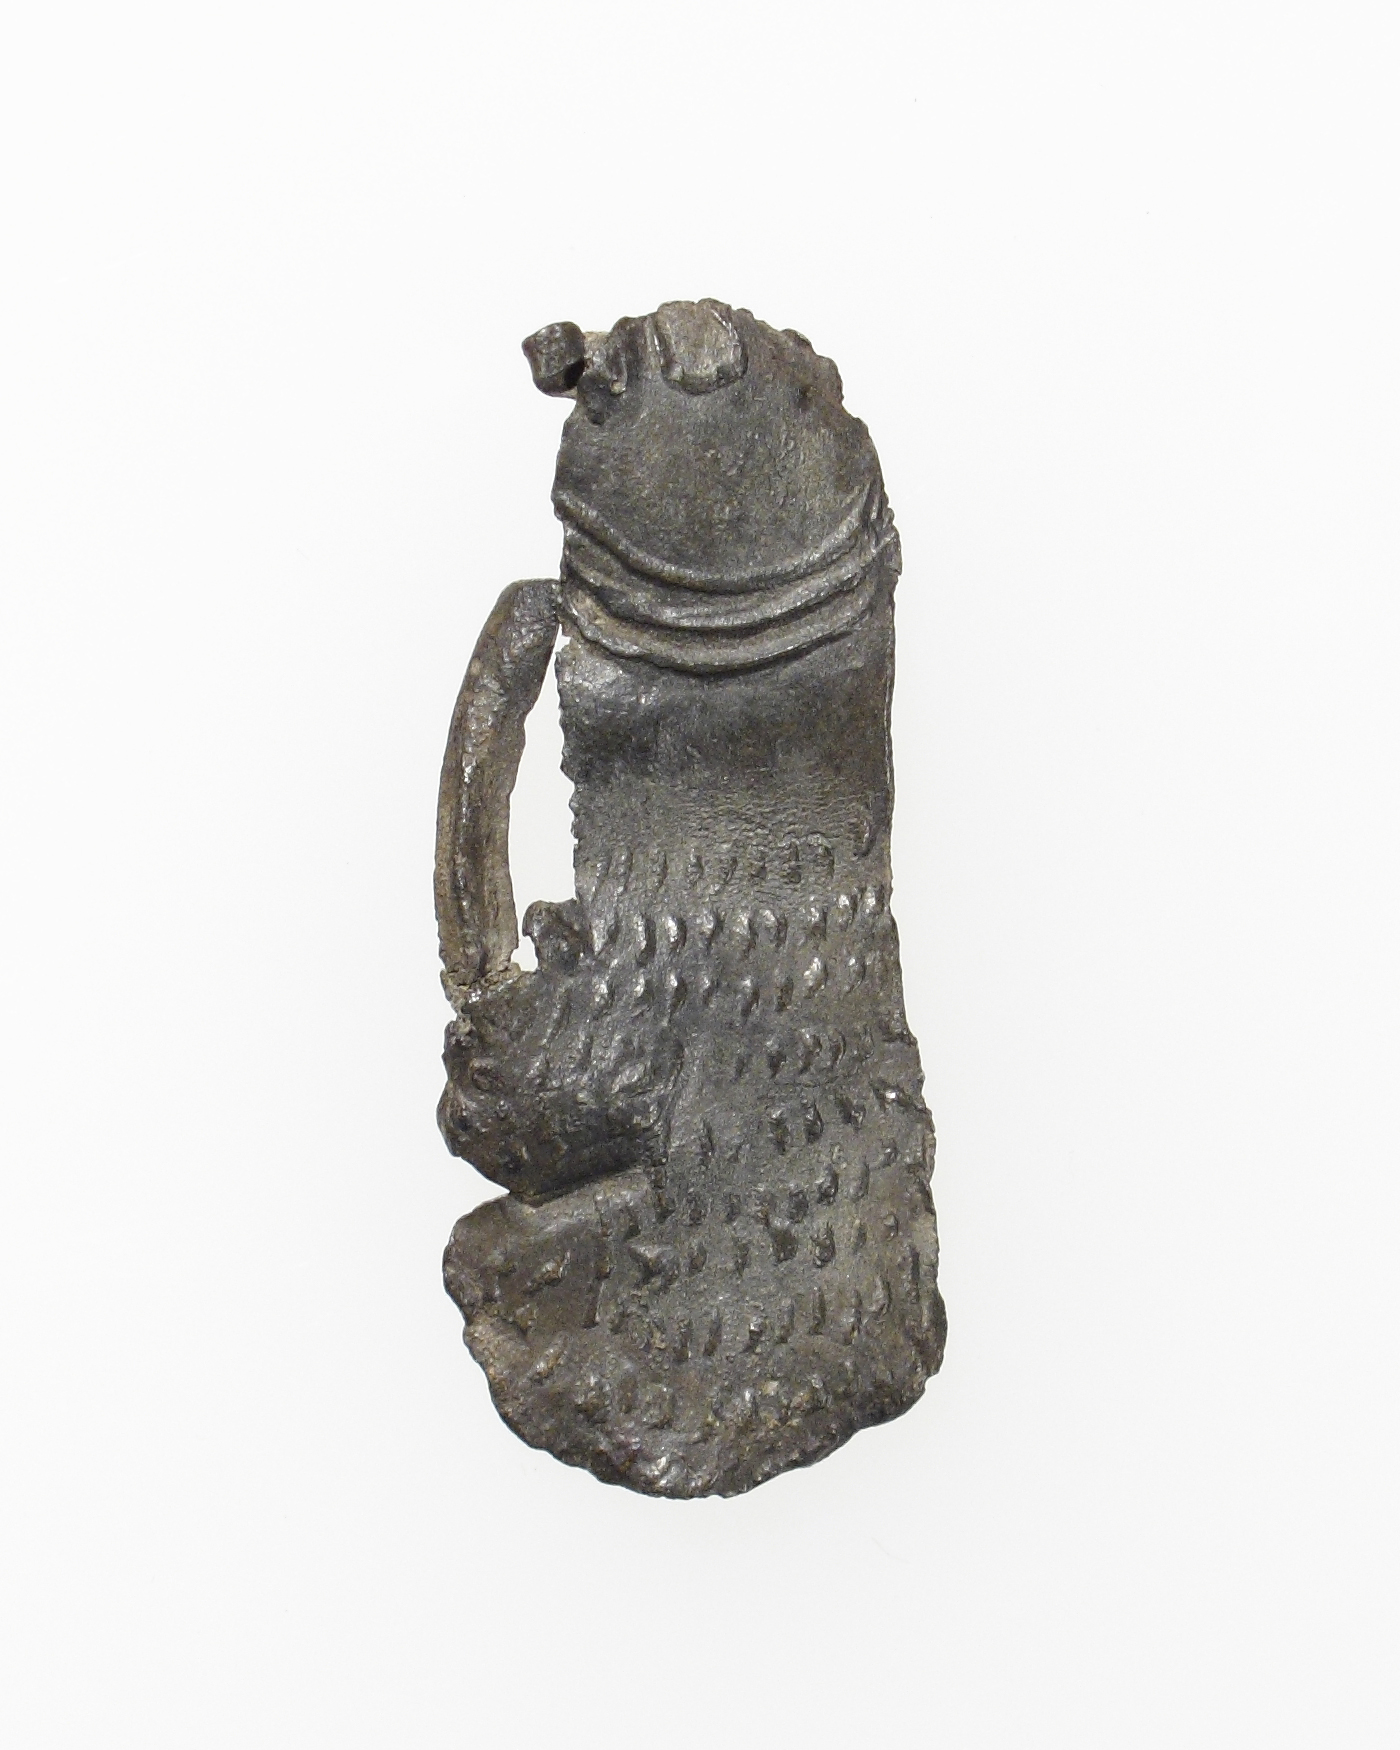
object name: pilgrim's badge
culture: french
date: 1301-1600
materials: lead